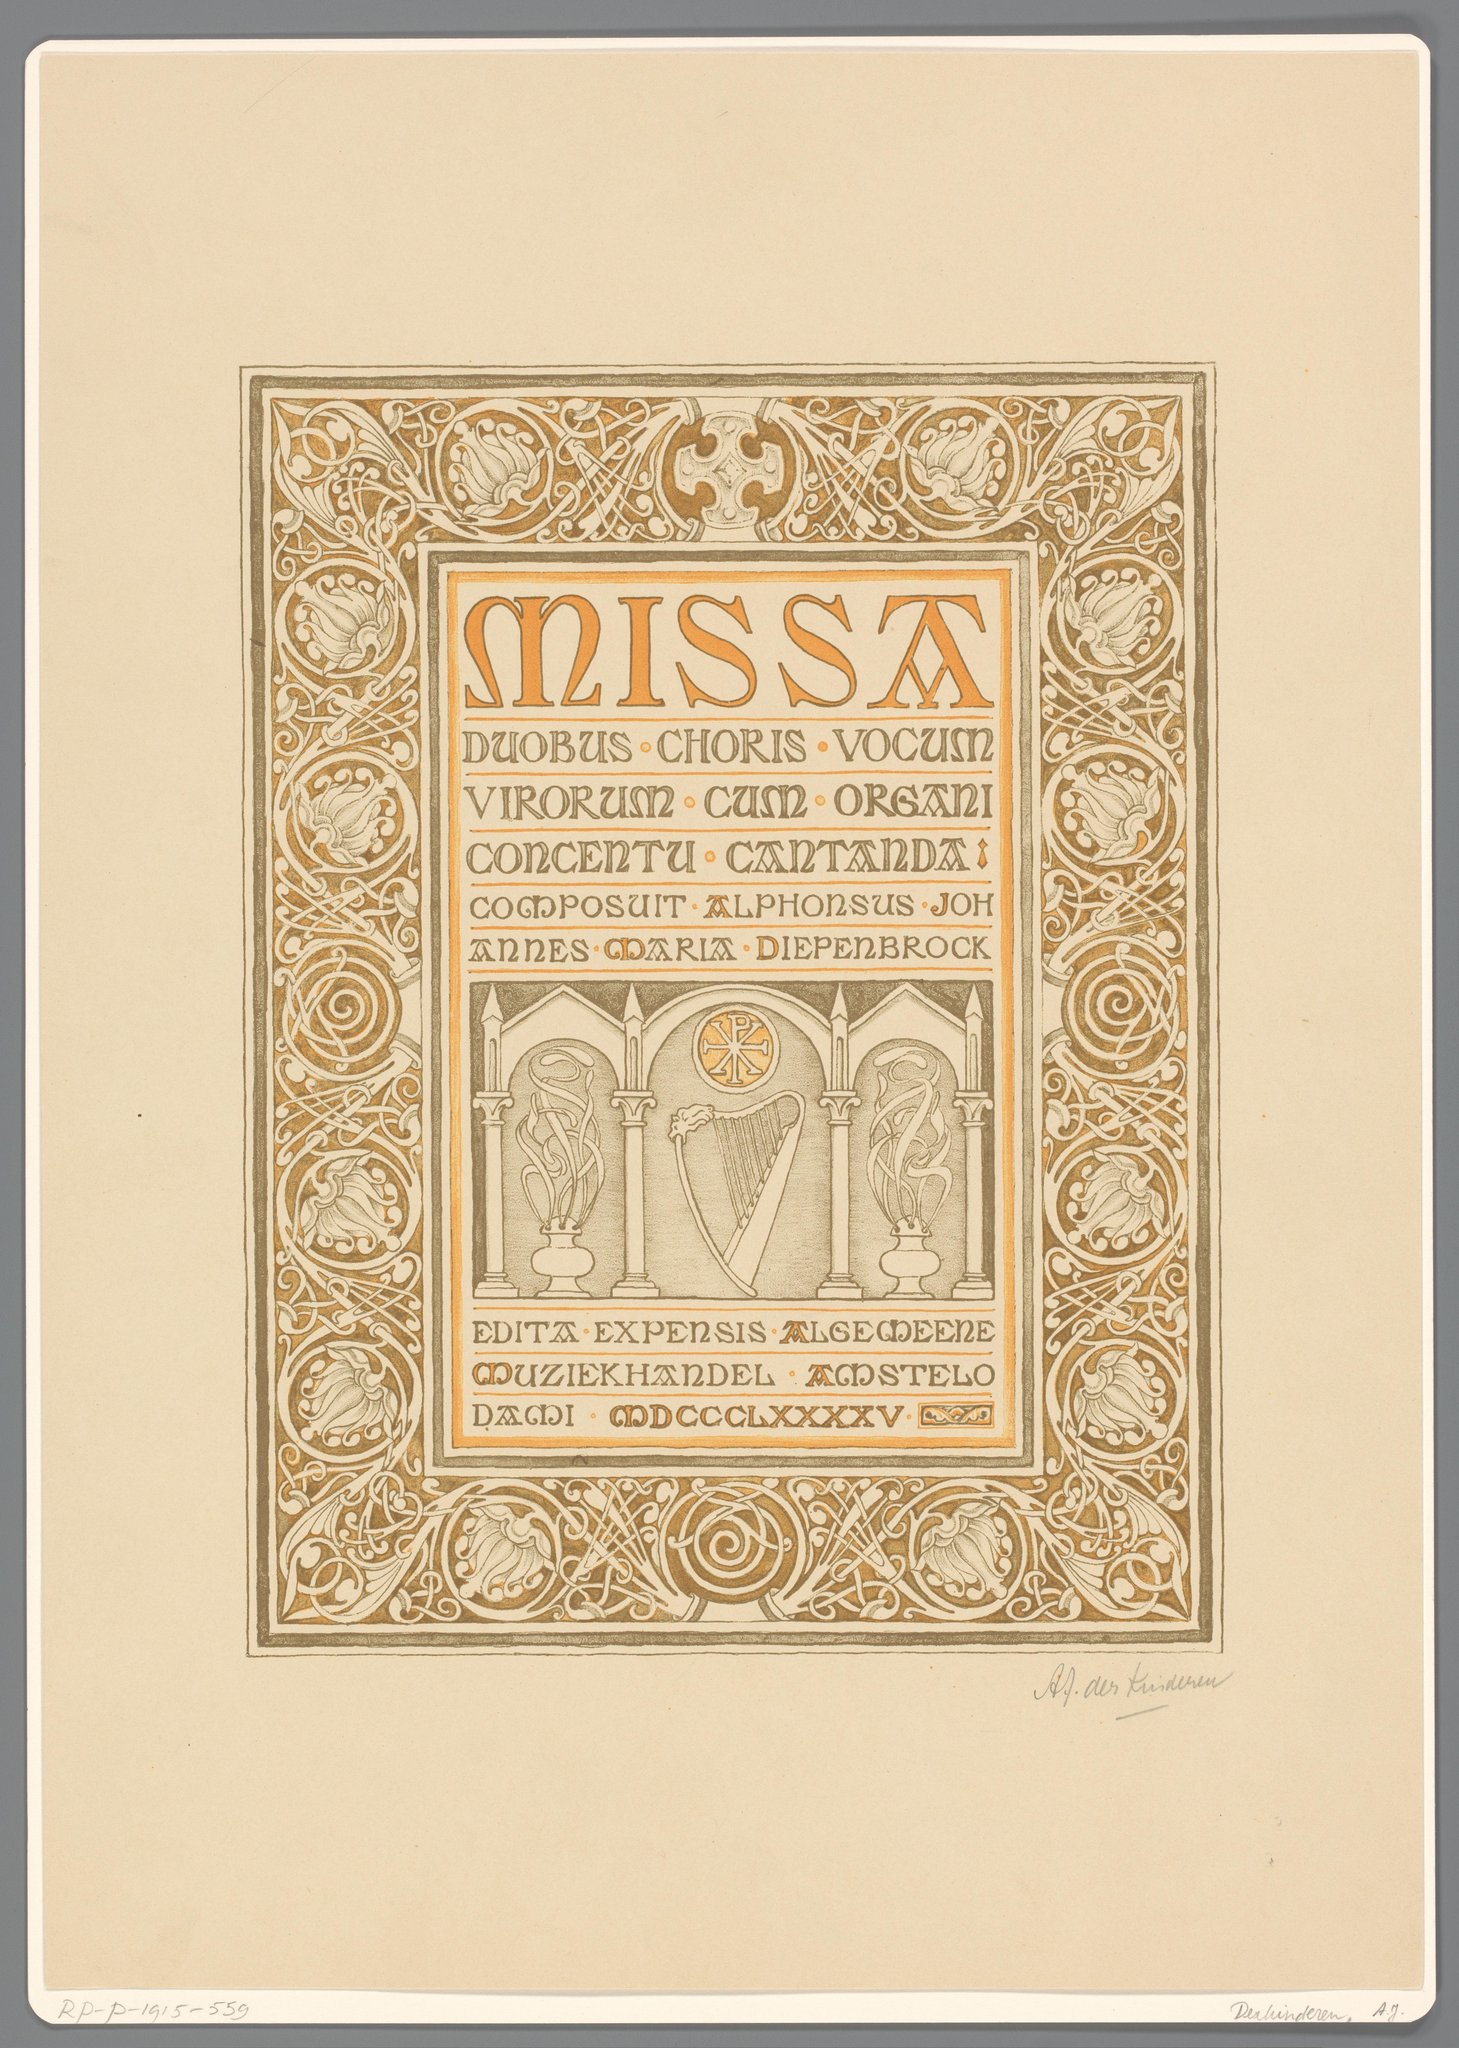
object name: print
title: Titelpagina van de Missa van Alphons Diepenbrock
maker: antoon derkinderen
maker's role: draughtsman, painter, print maker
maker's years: 1859-1925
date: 1895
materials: paper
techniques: lithograph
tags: alphons diepenbrock, incense used in the church, labarum, i.e. imperial standard bearing the christogram ihs, harp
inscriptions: collector's mark: Lugt 2233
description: Een rechthoekig kader dat versierd is met bloem- en plantmotieven. In het kader een doorsnede van een kerkgebouw met daarin een harp, twee wierookvaten en het Christusmonogram.